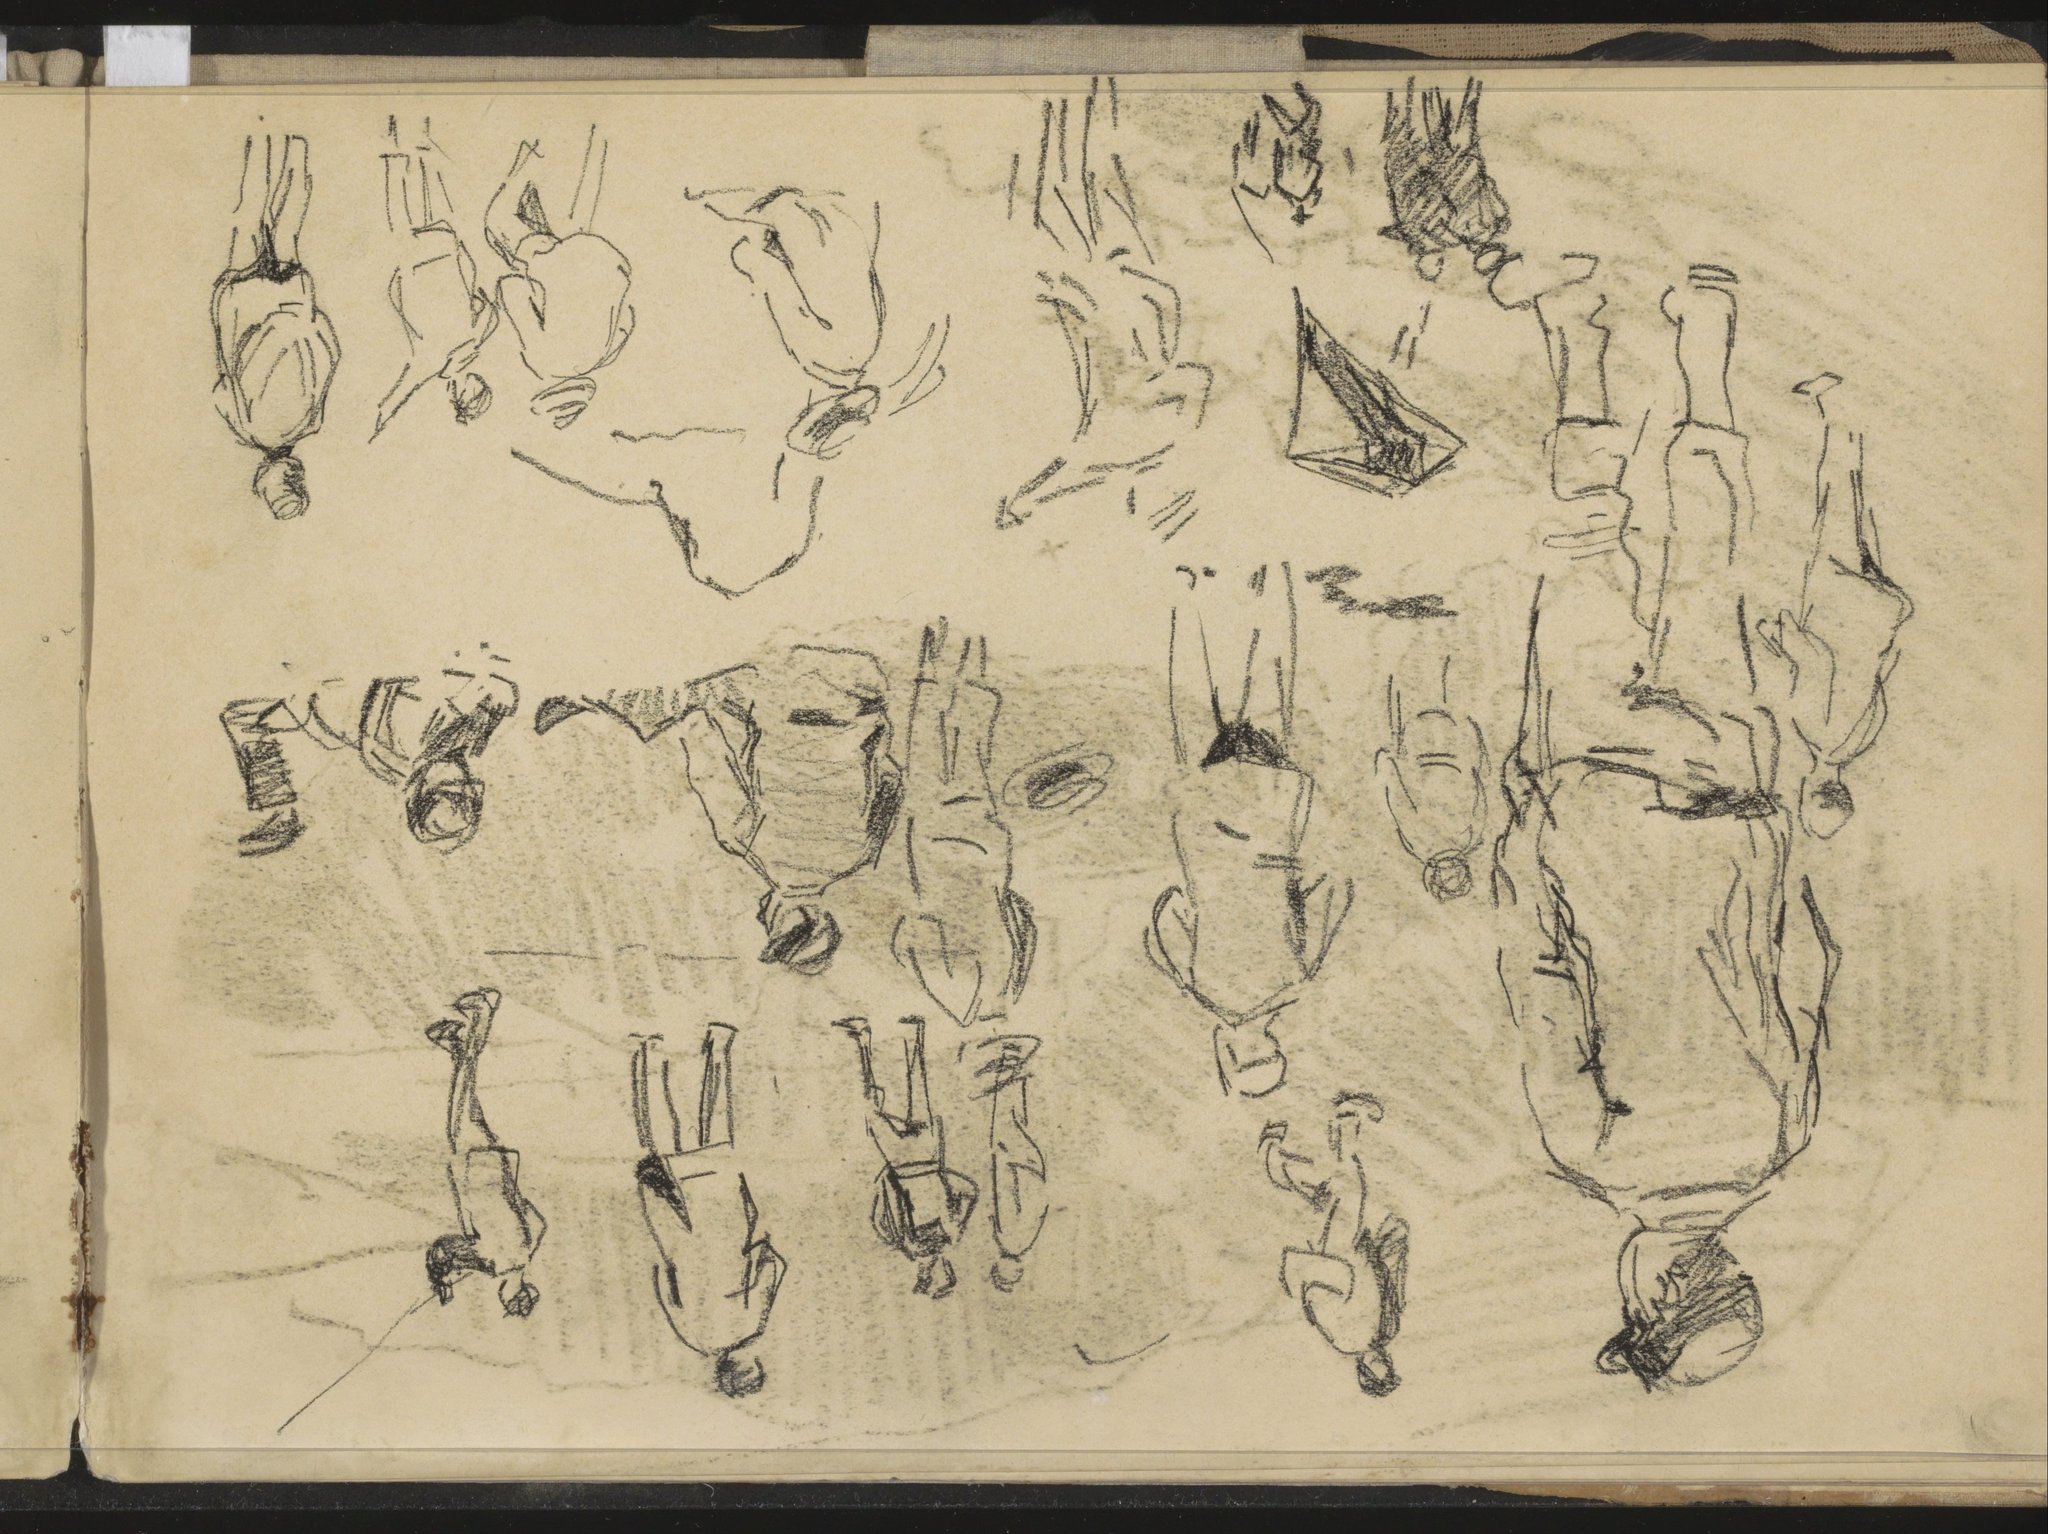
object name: sketchbook leaf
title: Vliegerende mannen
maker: willem bastiaan tholen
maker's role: draughtsman, painter, print maker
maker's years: 1860-1931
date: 1885-1931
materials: chalk, paper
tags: sitting figure, adult man, (flying a) kite, index finger forwards, pointing, indicating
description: De mannen zijn in verschillende houdingen getekend: zittend, lopend, vliegerend en kijkend en wijzend naar de vlieger. Blad 14 recto uit een schetsboek met 28 bladen.